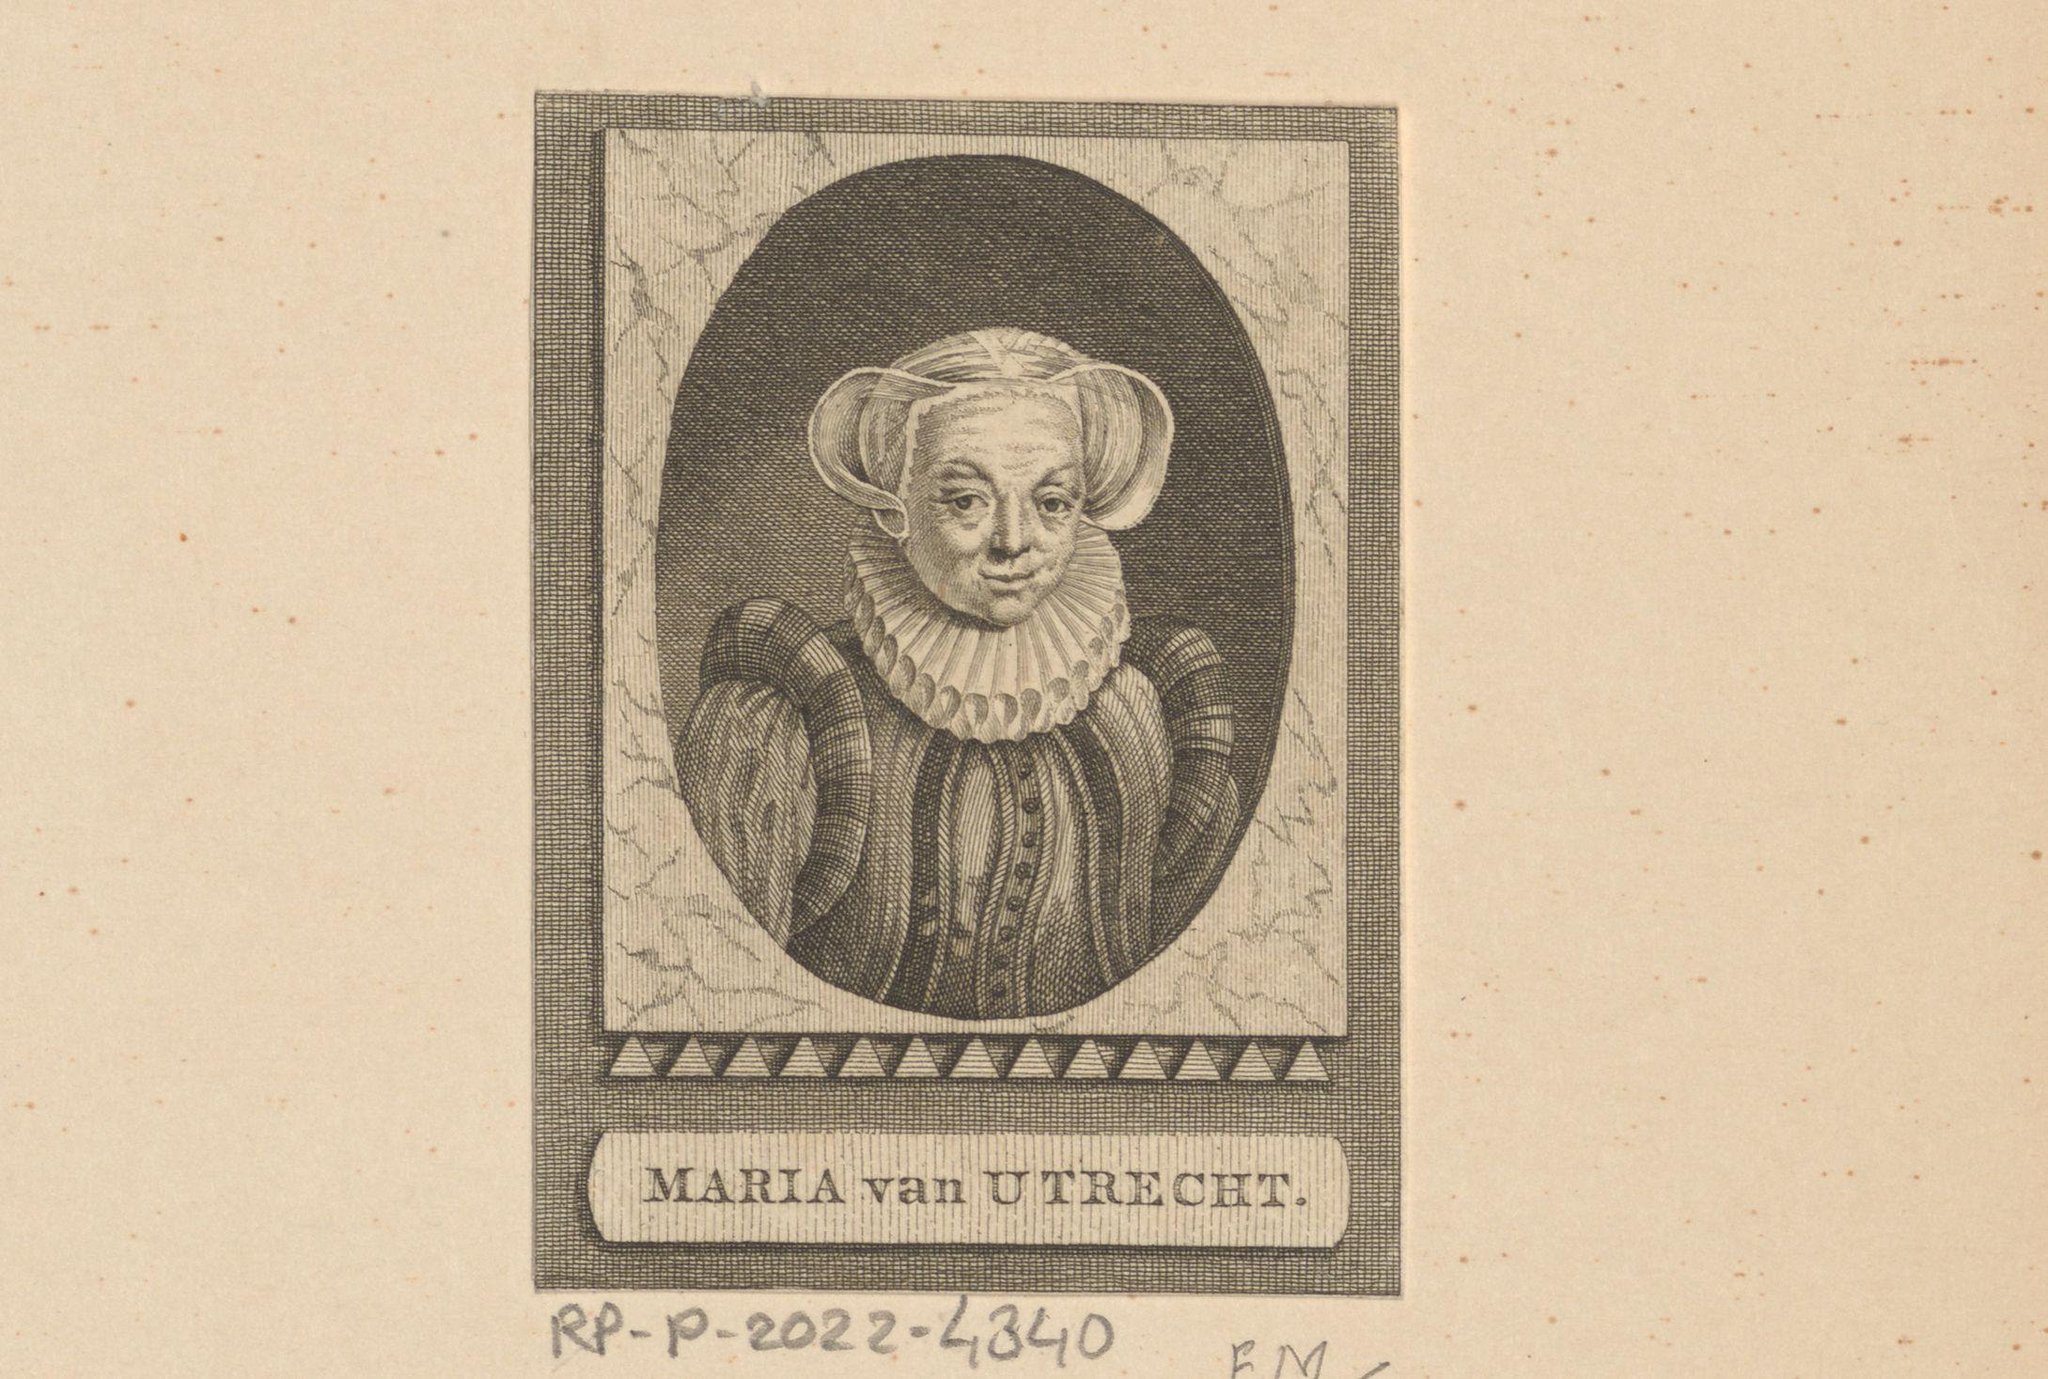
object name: print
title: Portret van Maria van Utrecht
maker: Anonymous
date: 1730-1800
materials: paper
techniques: etching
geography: northern netherlands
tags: historical persons - bb - woman